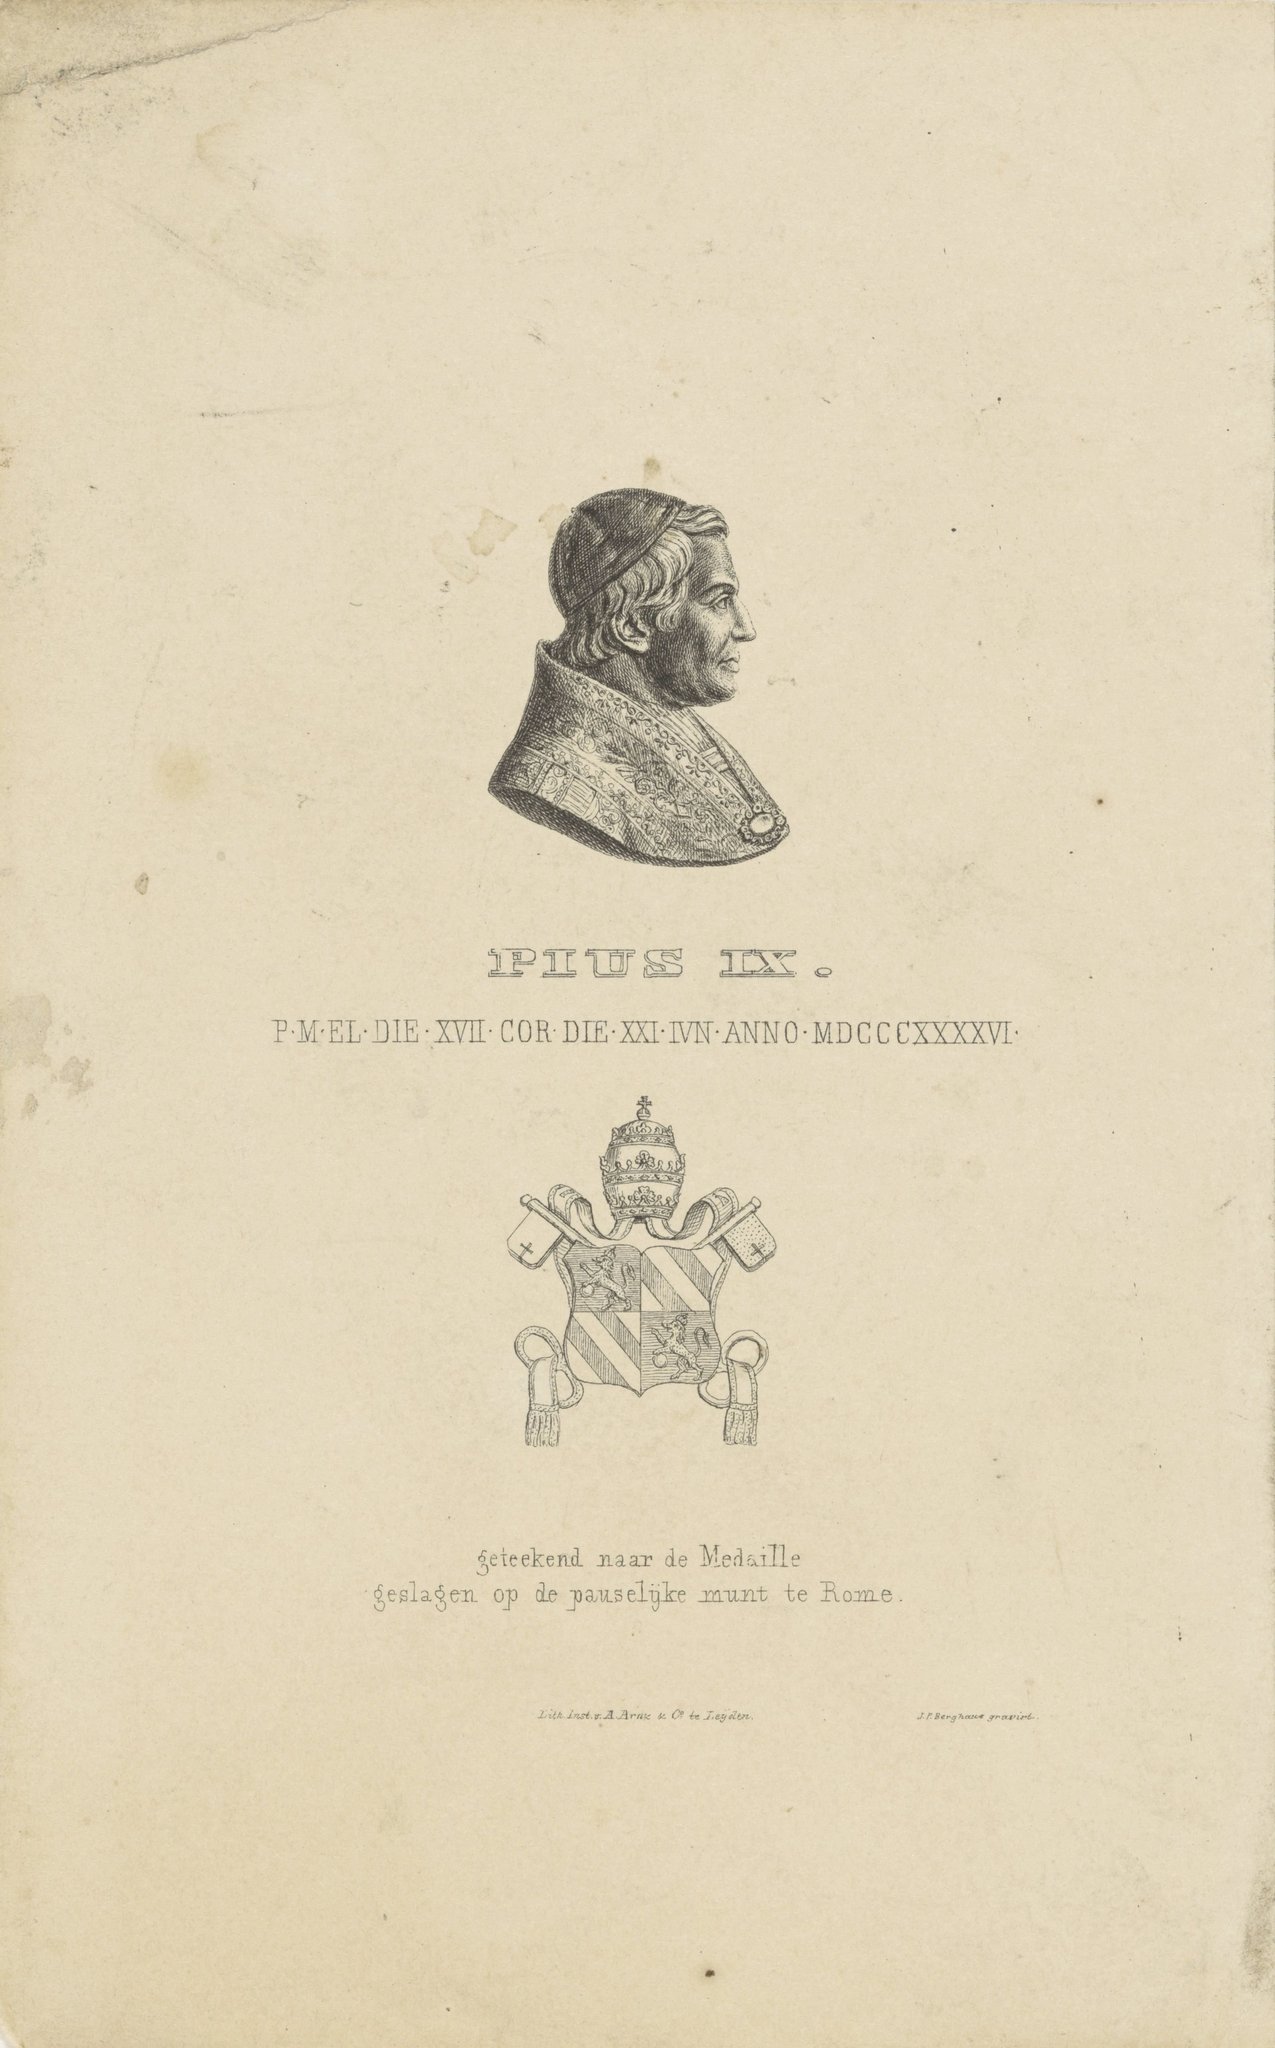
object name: print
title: Portret van paus Pius IX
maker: johann peter berghaus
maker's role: print maker, printer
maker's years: 1810-1870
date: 1820-1870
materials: paper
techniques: lithograph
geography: leiden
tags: rome, insignia of the pope, e.g. tiara, historical persons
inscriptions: collector's mark: Lugt 2228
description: De paus is en profil als een reliëf afgebeeld. Onder het portret zijn naam en Latijnse letters en cijfers. Daaronder zijn pauselijk wapen en de woorden: geteekend naar de Medaille geslagen op de pauselijke munt te Rome.